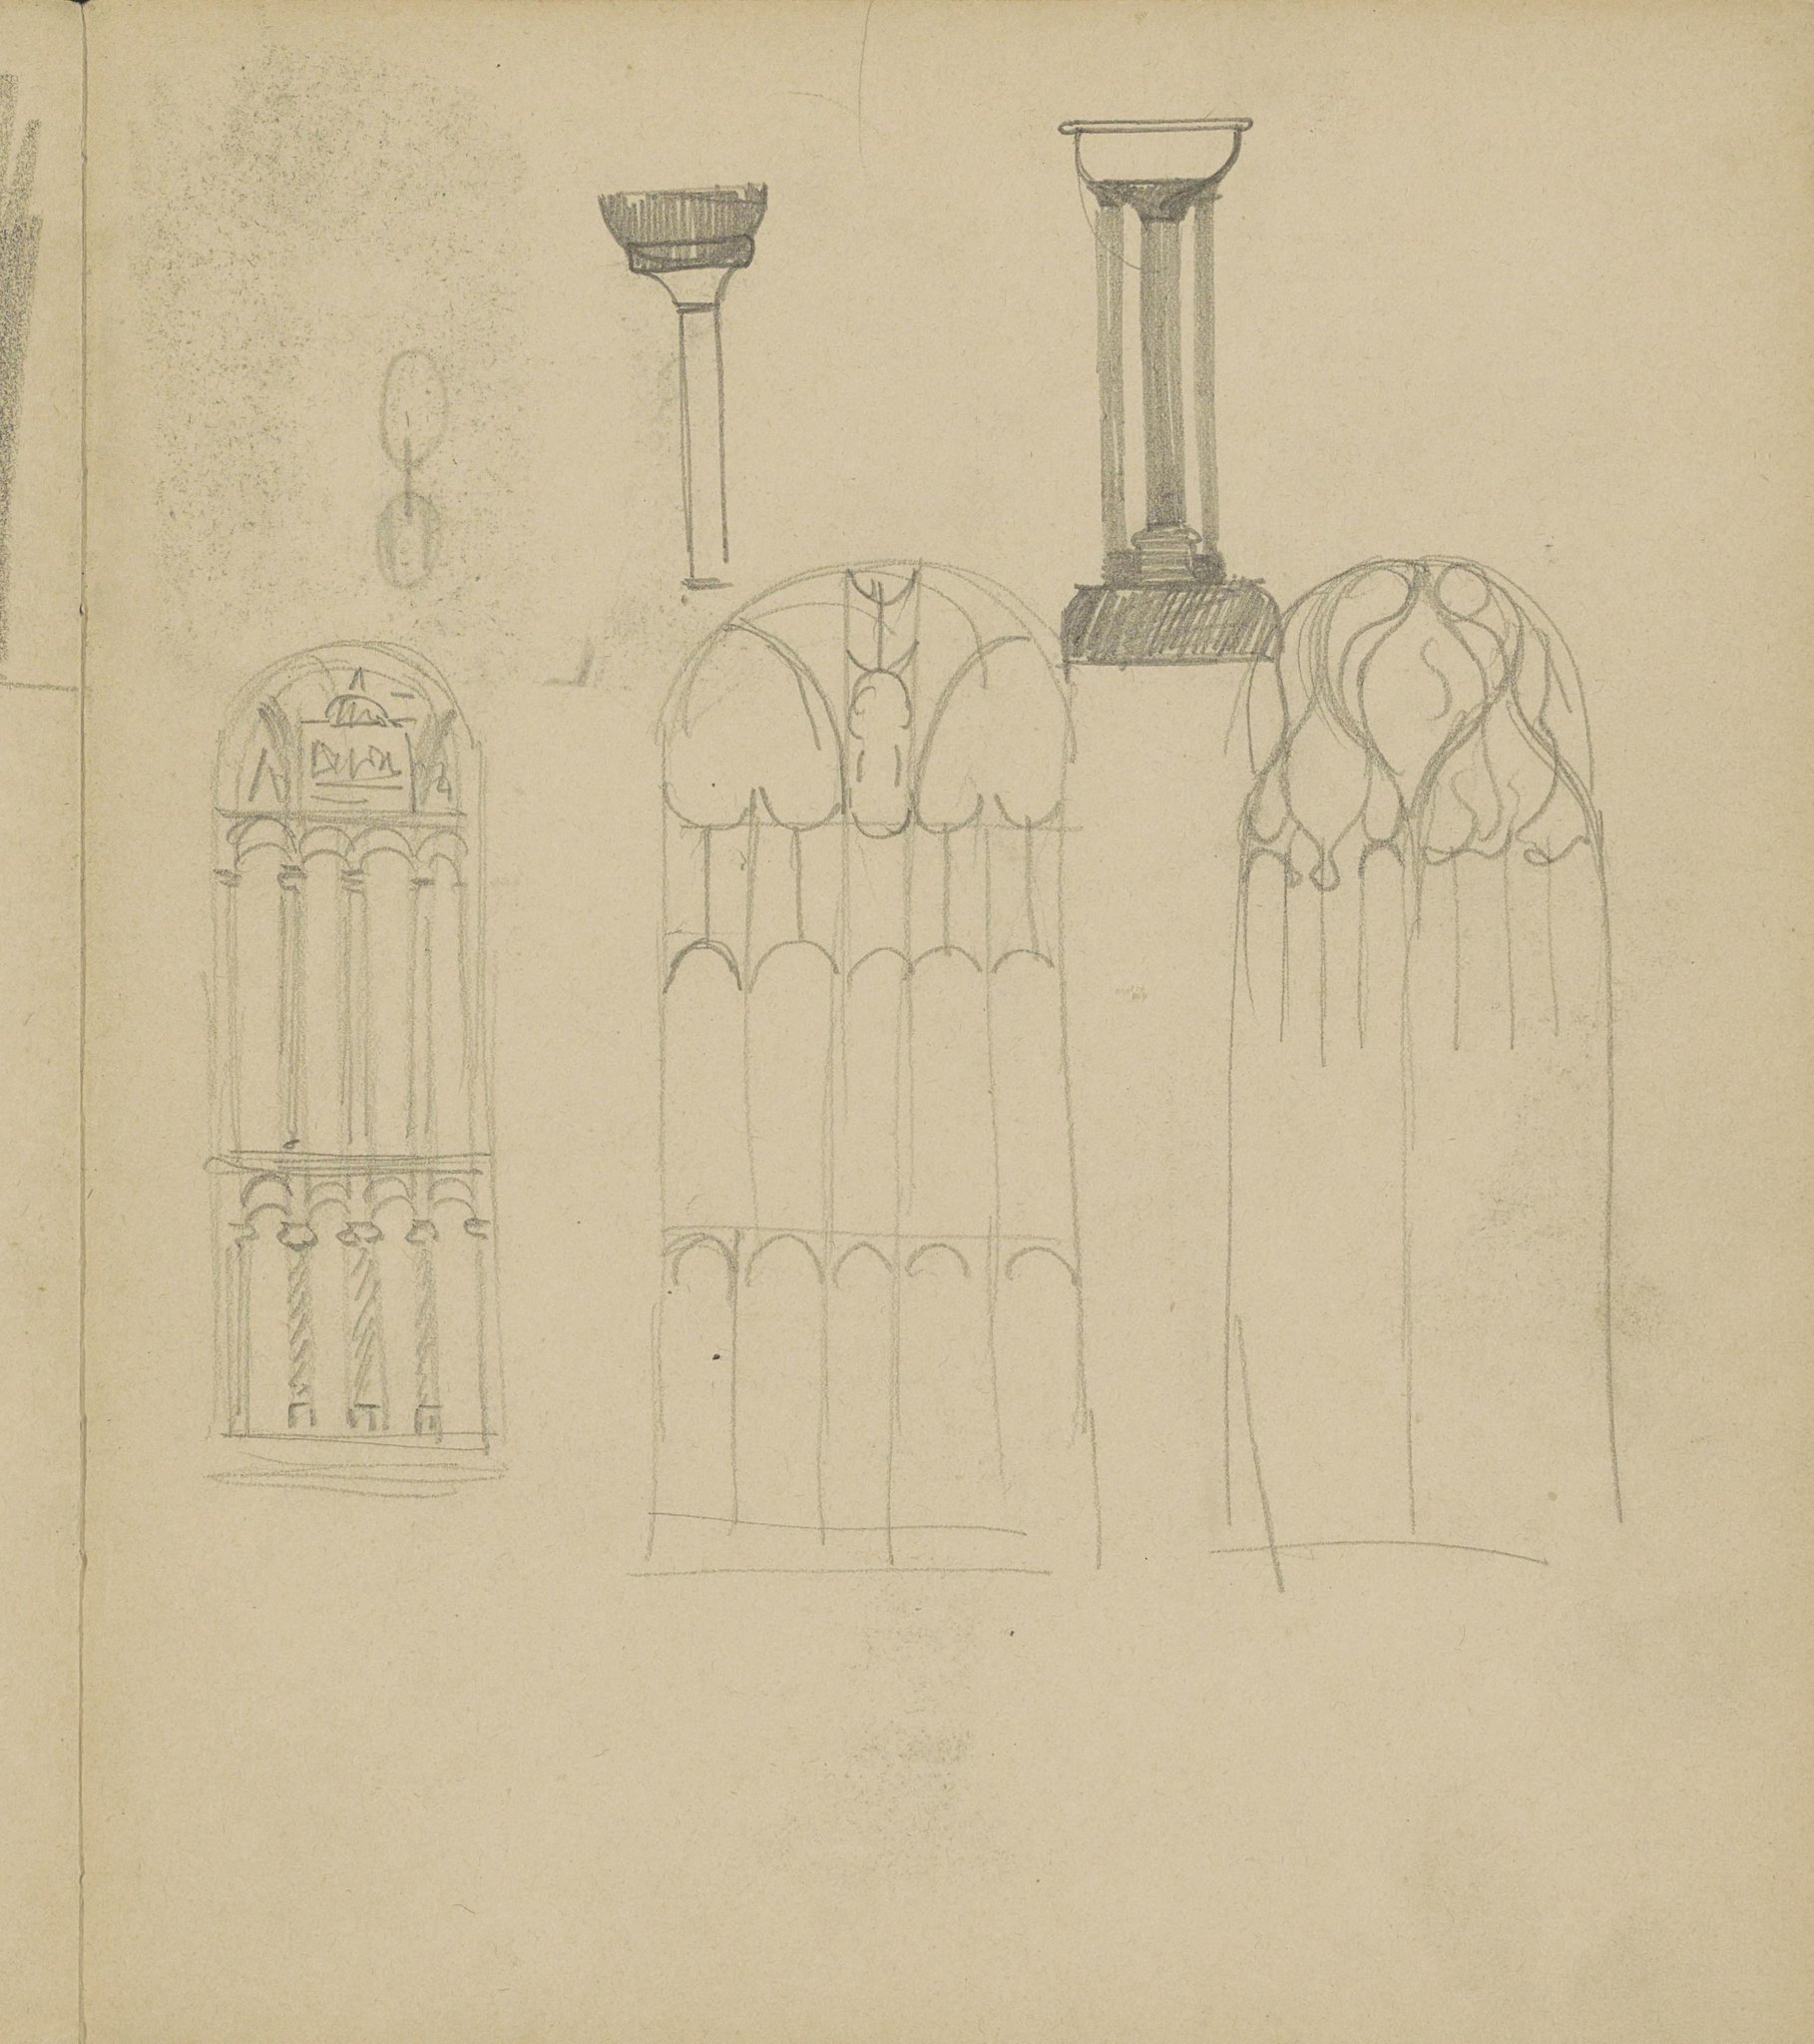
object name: sketchbook leaf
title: Doopvont en kerkramen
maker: carel adolph lion cachet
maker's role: draughtsman, print maker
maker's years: 1864-1945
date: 1905-1906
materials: paper, pencil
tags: church-window, e.g. rose-window, baptismal font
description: Blad 4 recto uit een schetsboek met 30 bladen.